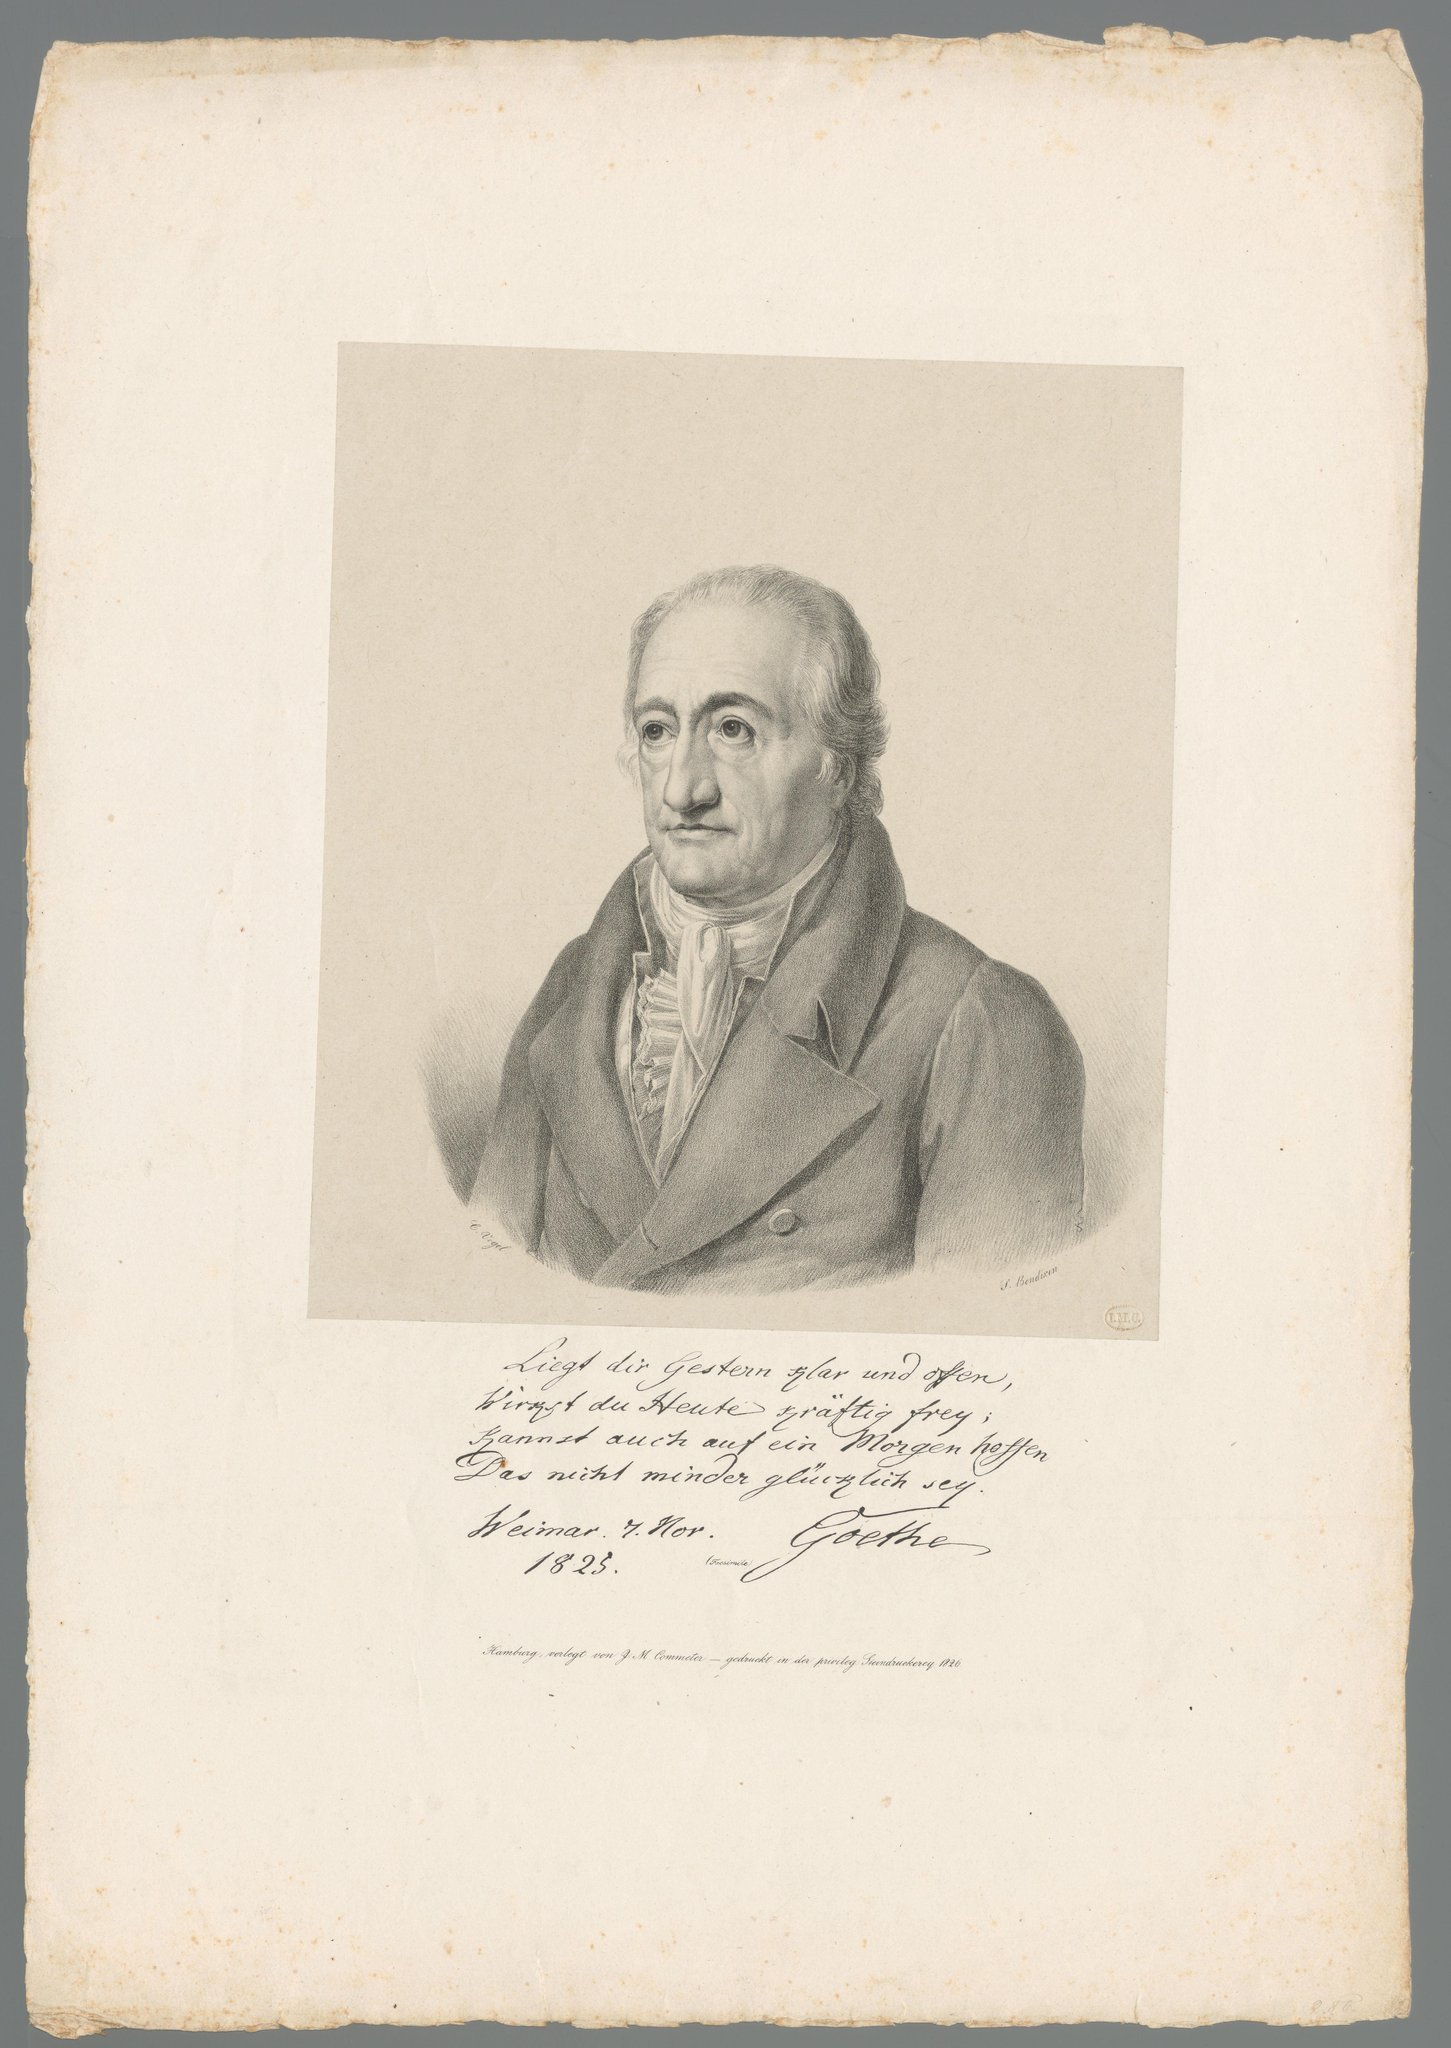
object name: print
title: Portret van Johann Wolfgang von Goethe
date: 1826-1864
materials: paper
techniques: lithograph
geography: hamburg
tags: draughtsman, johann wolfgang von goethe, adult man, historical persons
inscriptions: check stamp: ‘I.M.G.’, collector's mark: Lugt 2228